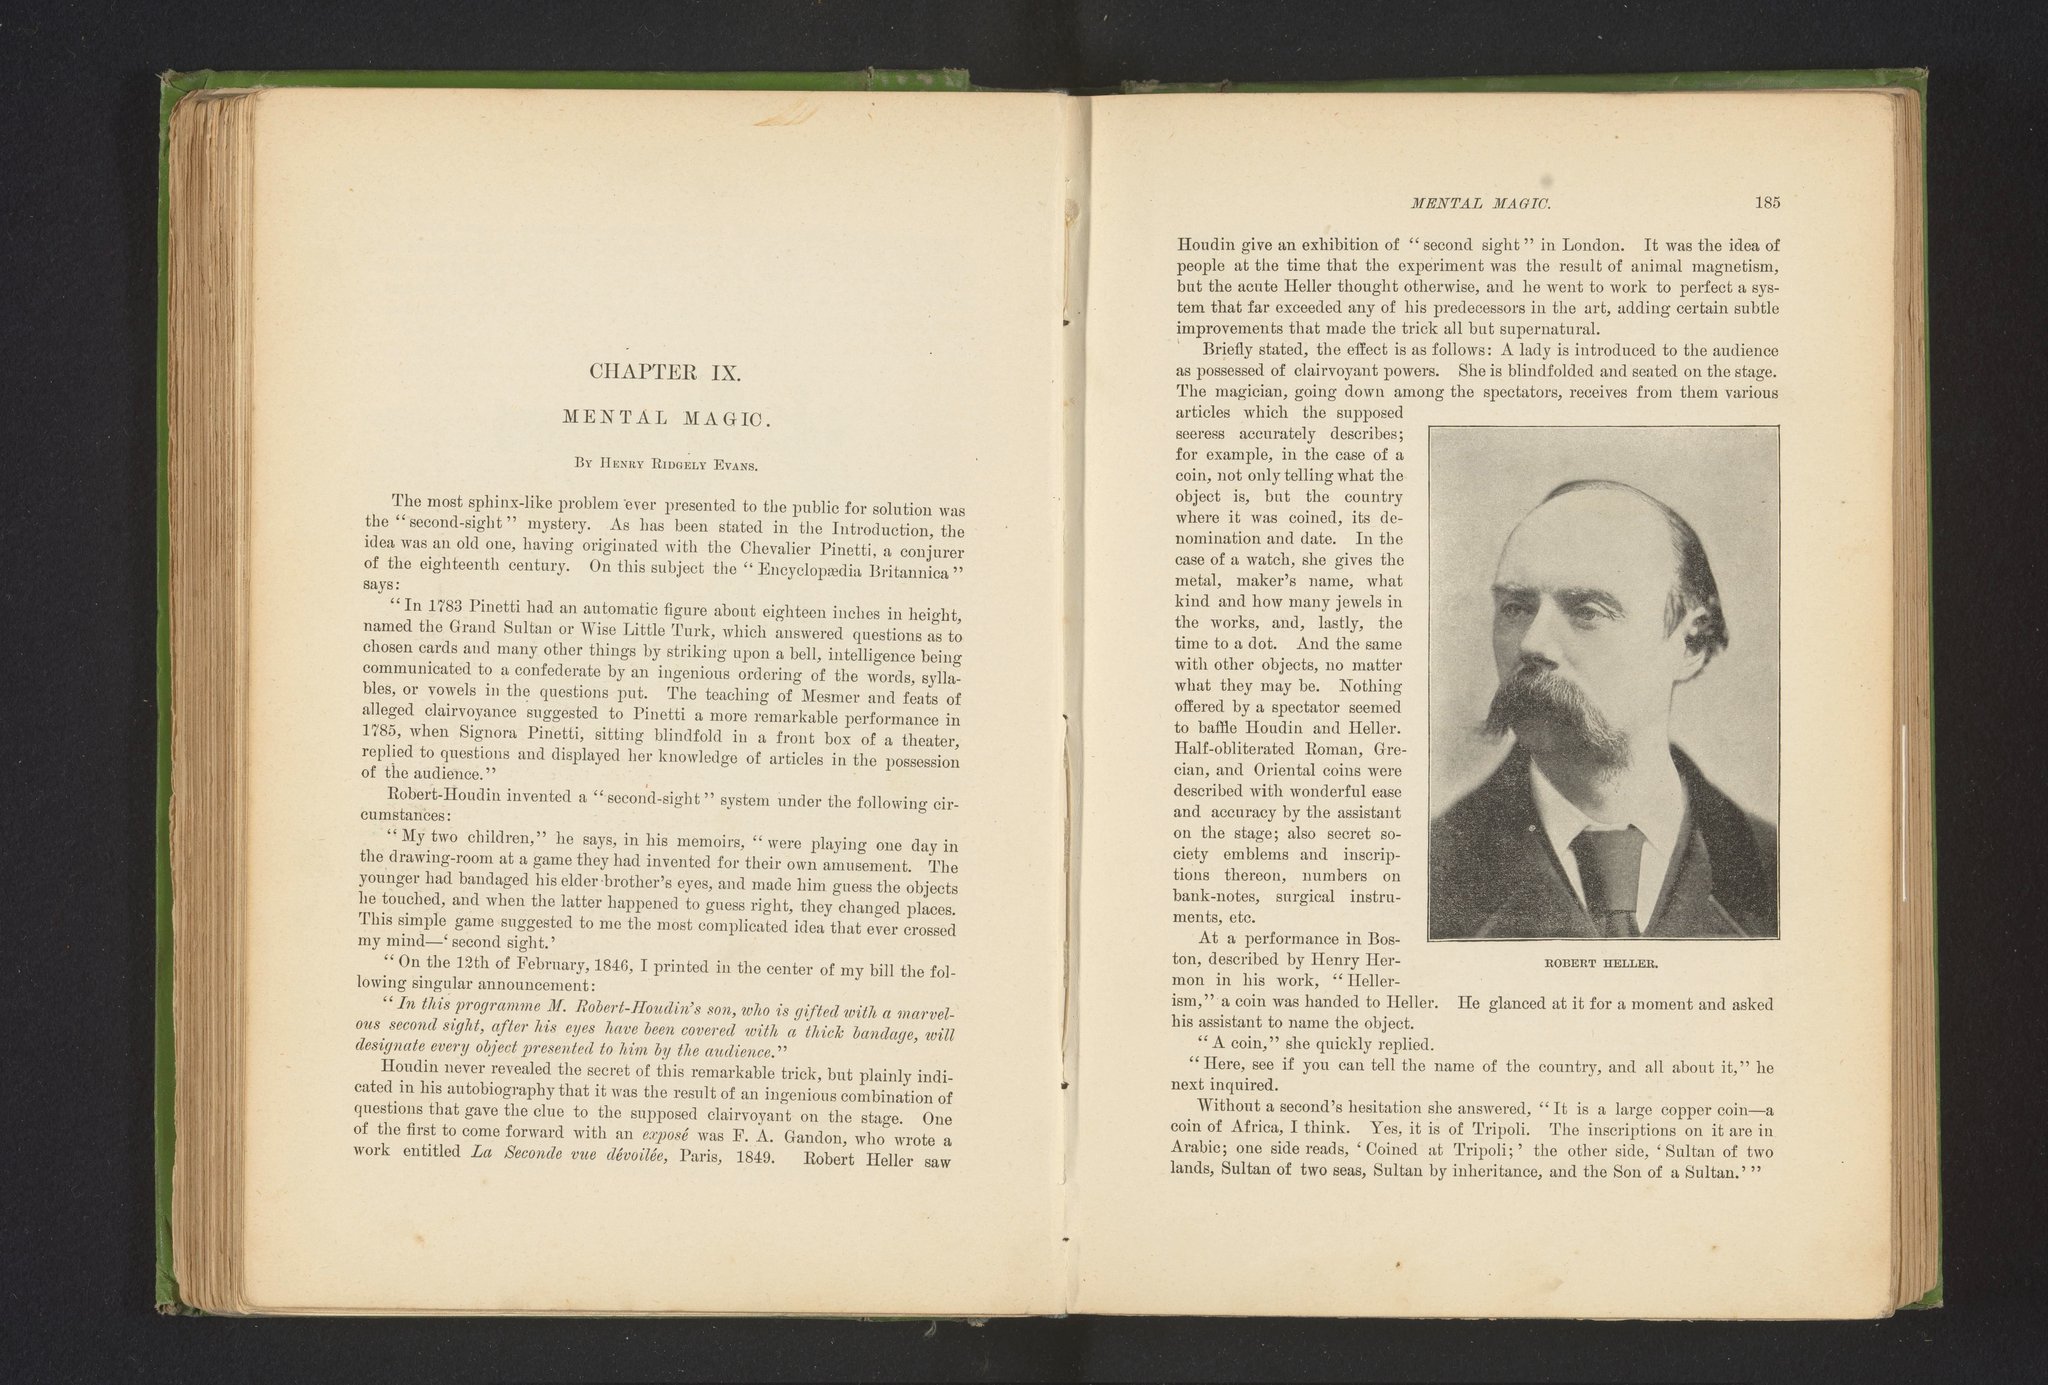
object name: page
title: Portret van Robert Heller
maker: Anonymous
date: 1892-1897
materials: paper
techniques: autotype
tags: historical persons